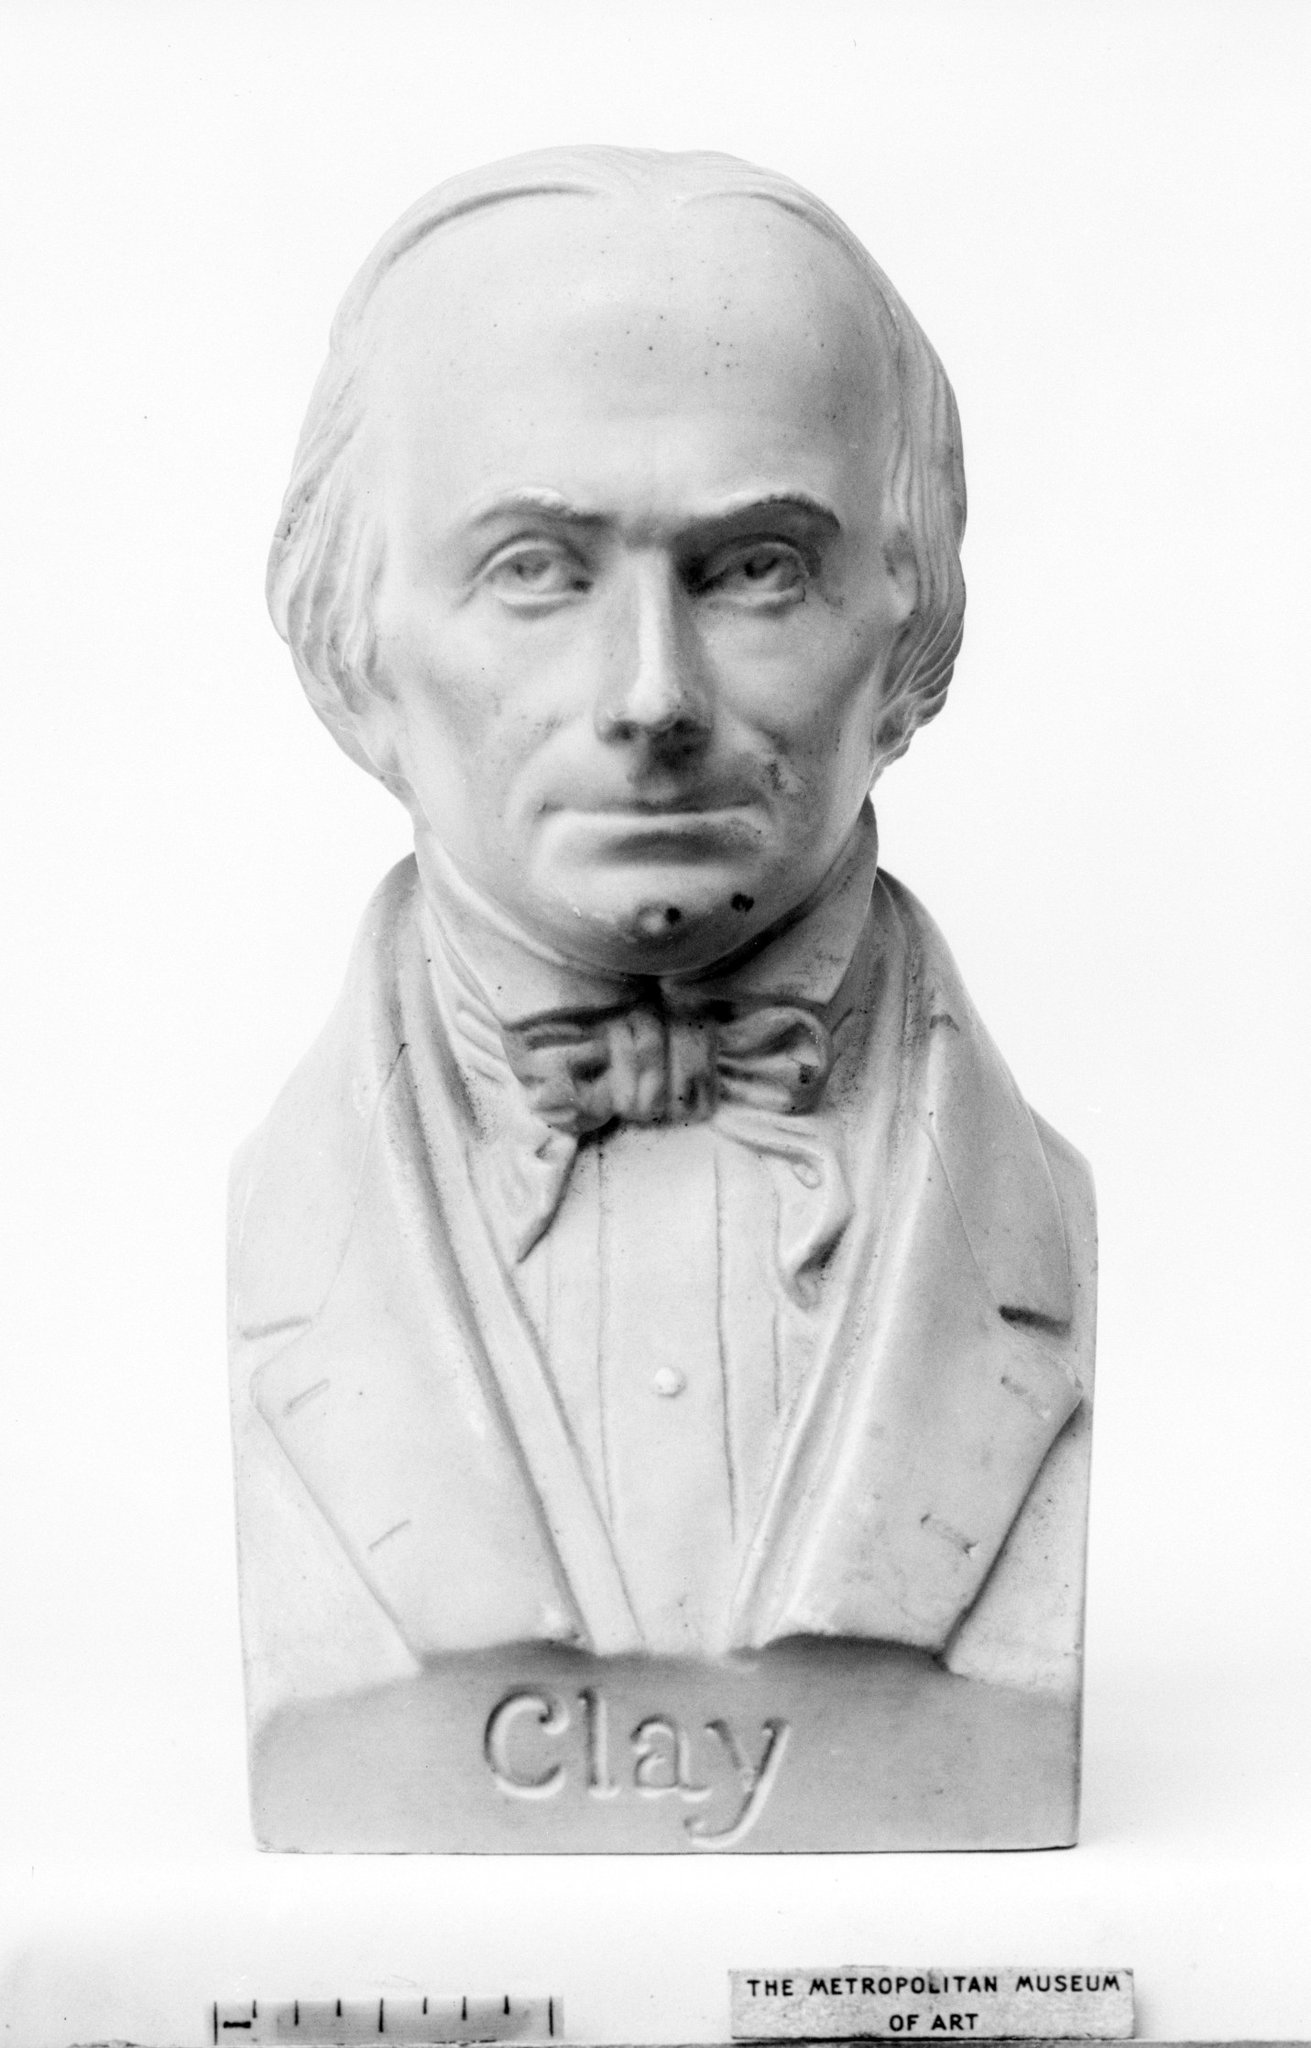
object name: bust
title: Bust of Henry Clay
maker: pierre joseph chardigny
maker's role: maker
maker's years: 1794-1866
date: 1853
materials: plaster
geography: france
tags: men